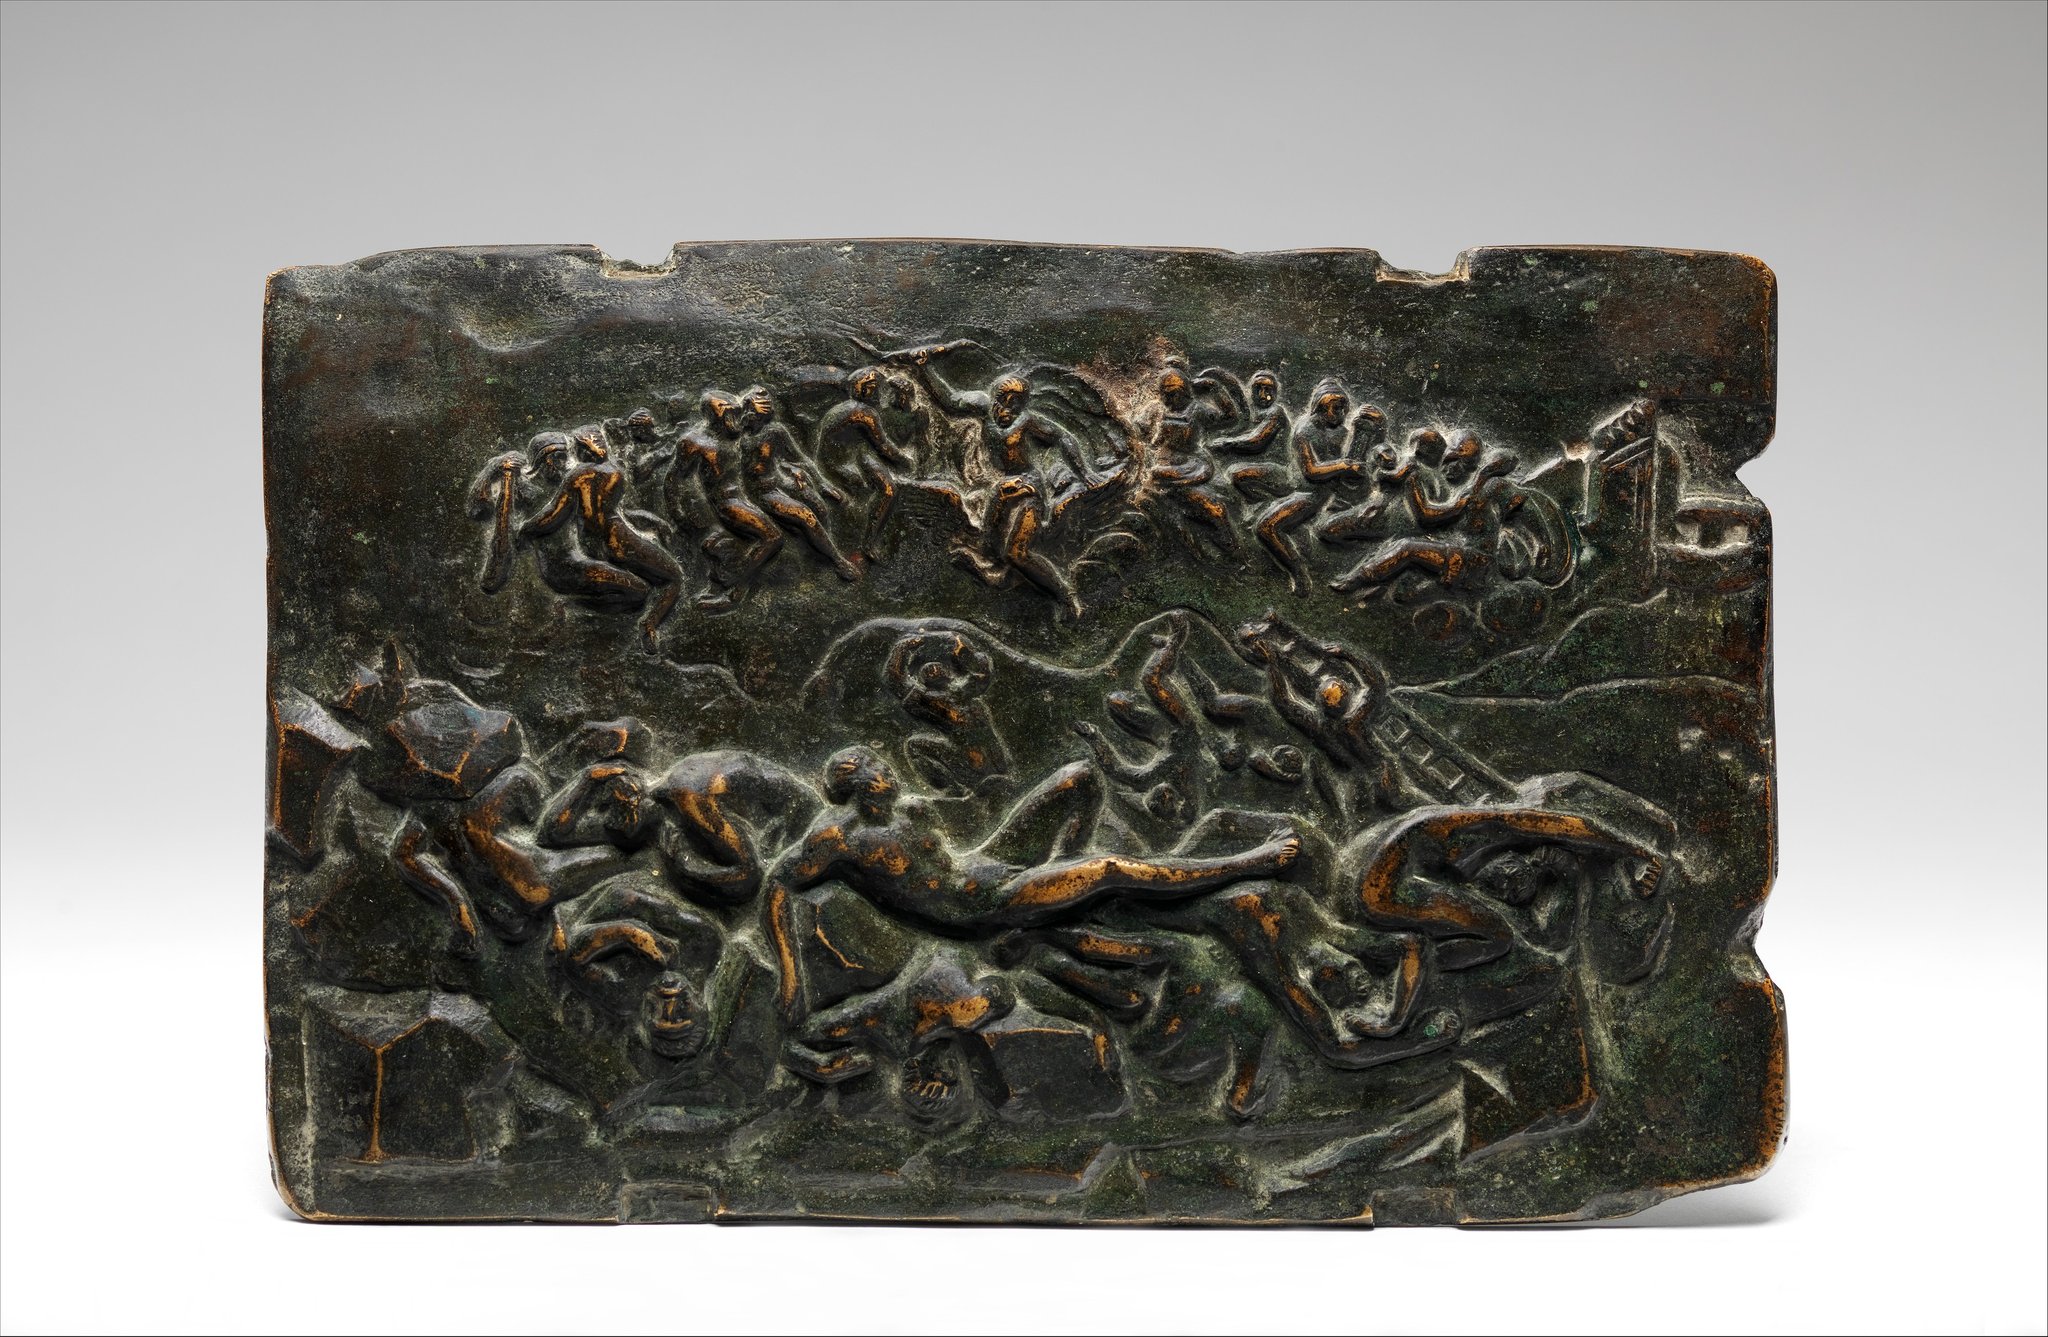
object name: plaquette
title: Downfall of the Giants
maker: fidia della porta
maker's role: artist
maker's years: 1538-1589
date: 1577-1586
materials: bronze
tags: human figures